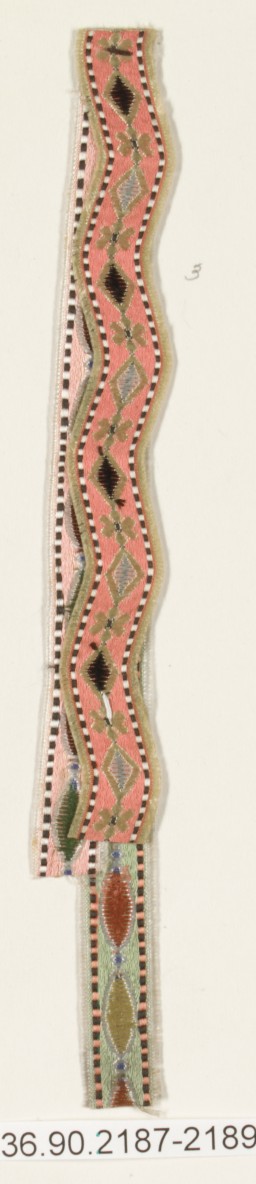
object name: piece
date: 1801-1900